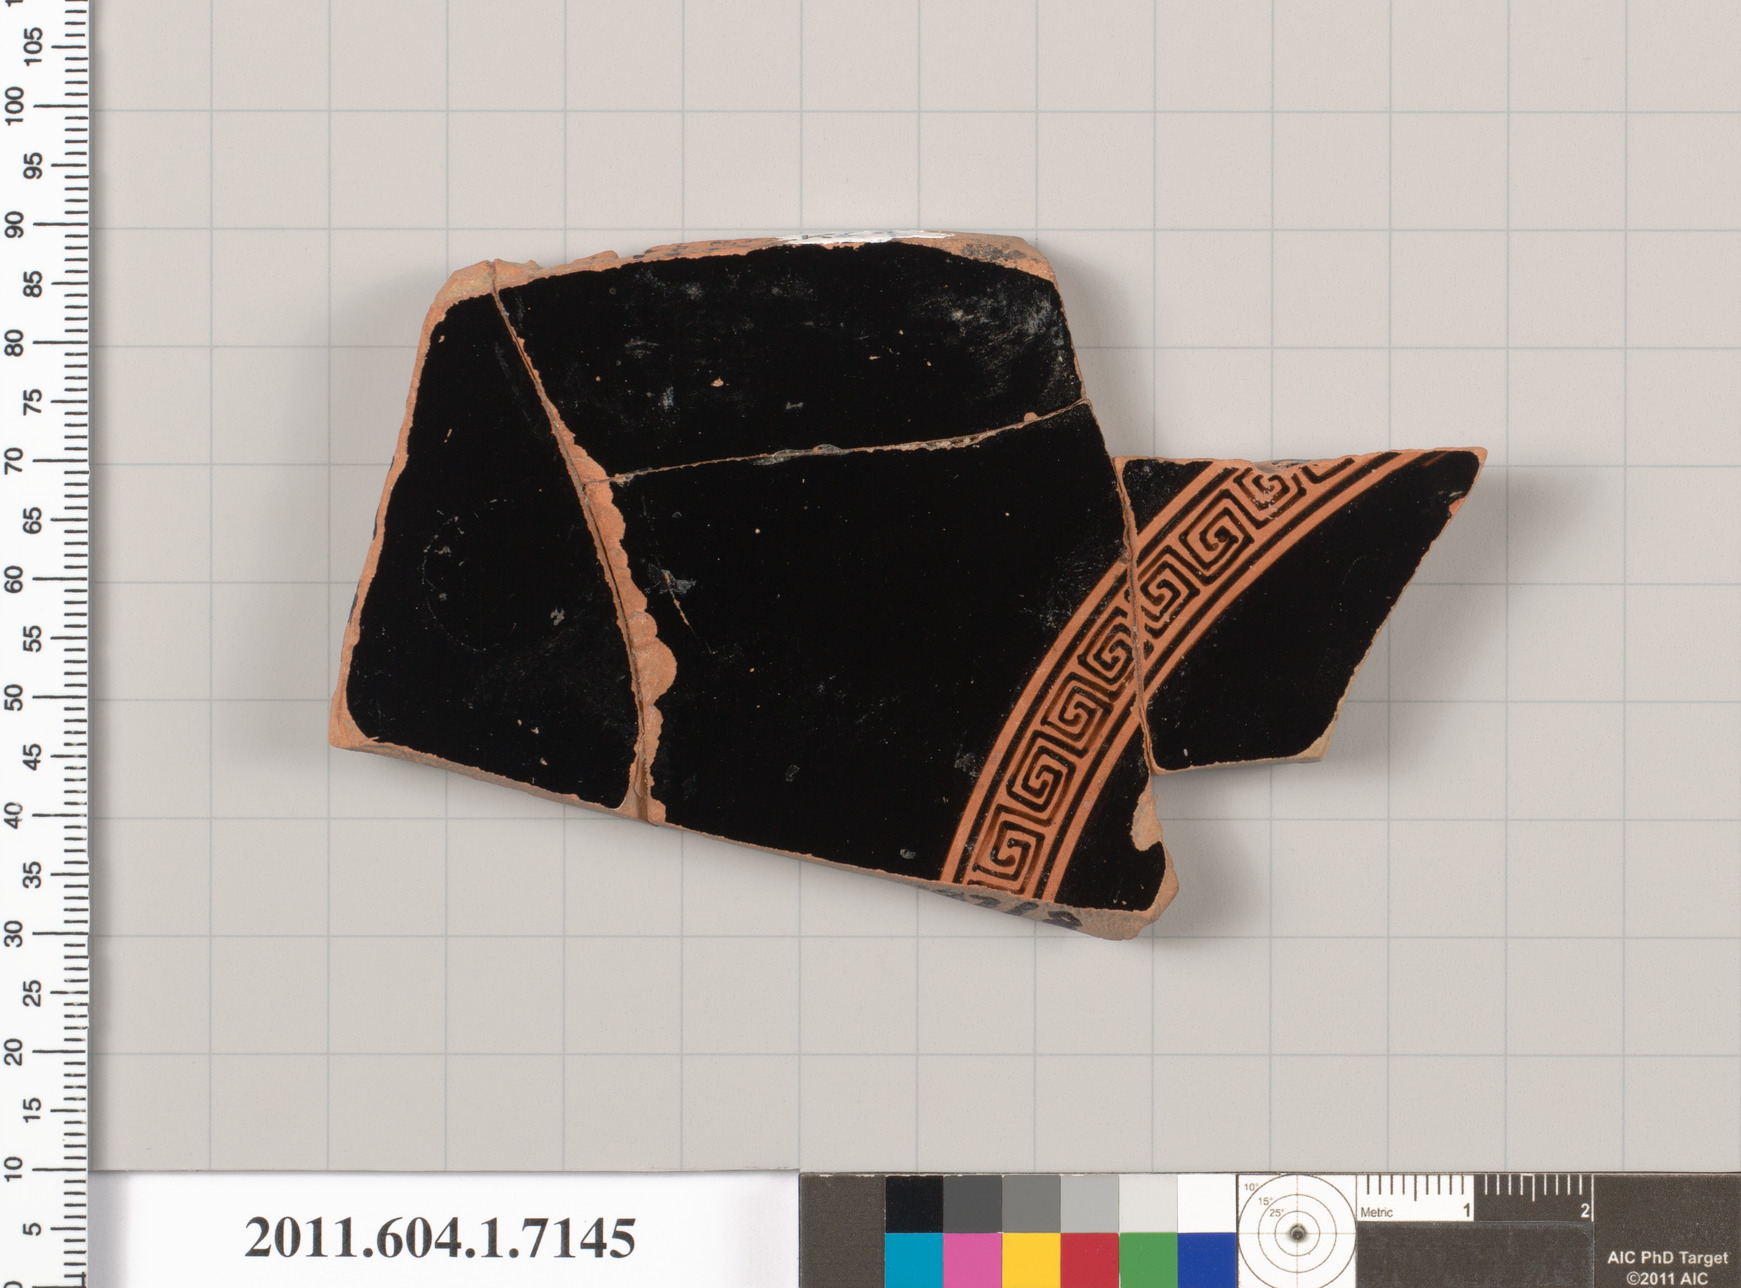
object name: kylix fragment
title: Terracotta fragment of a kylix (drinking cup)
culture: greek, attic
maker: makron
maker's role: artist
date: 500-480 BCE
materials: terracotta